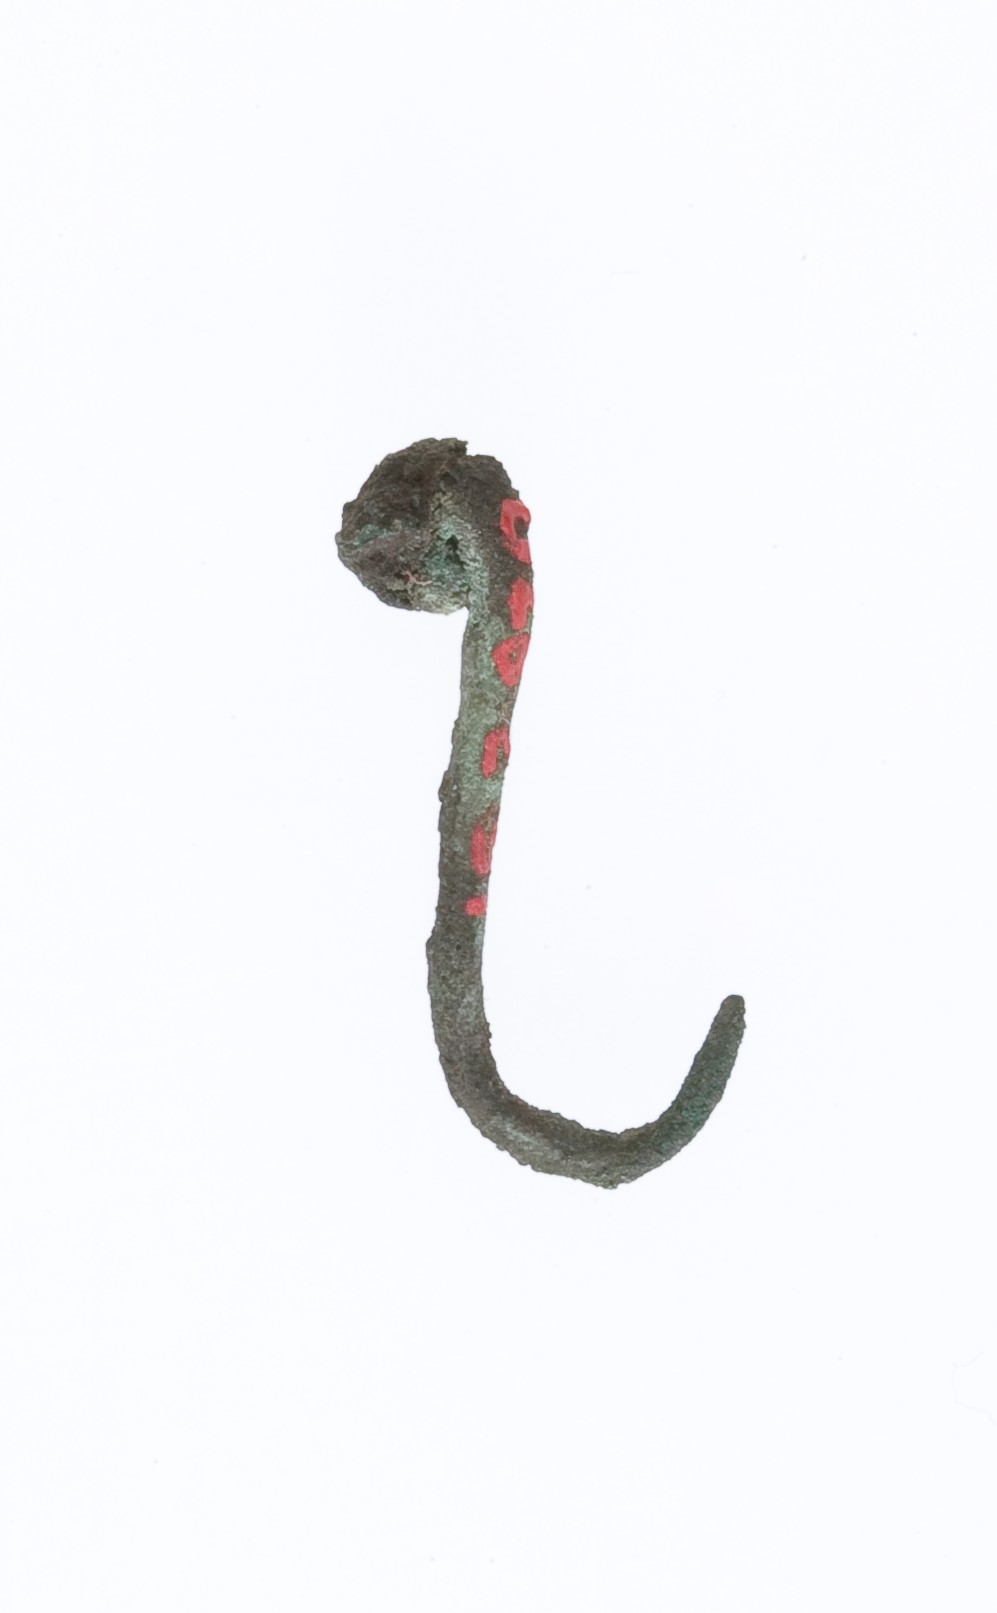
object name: fish hook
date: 1295-1070 BCE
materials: bronze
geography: egypt